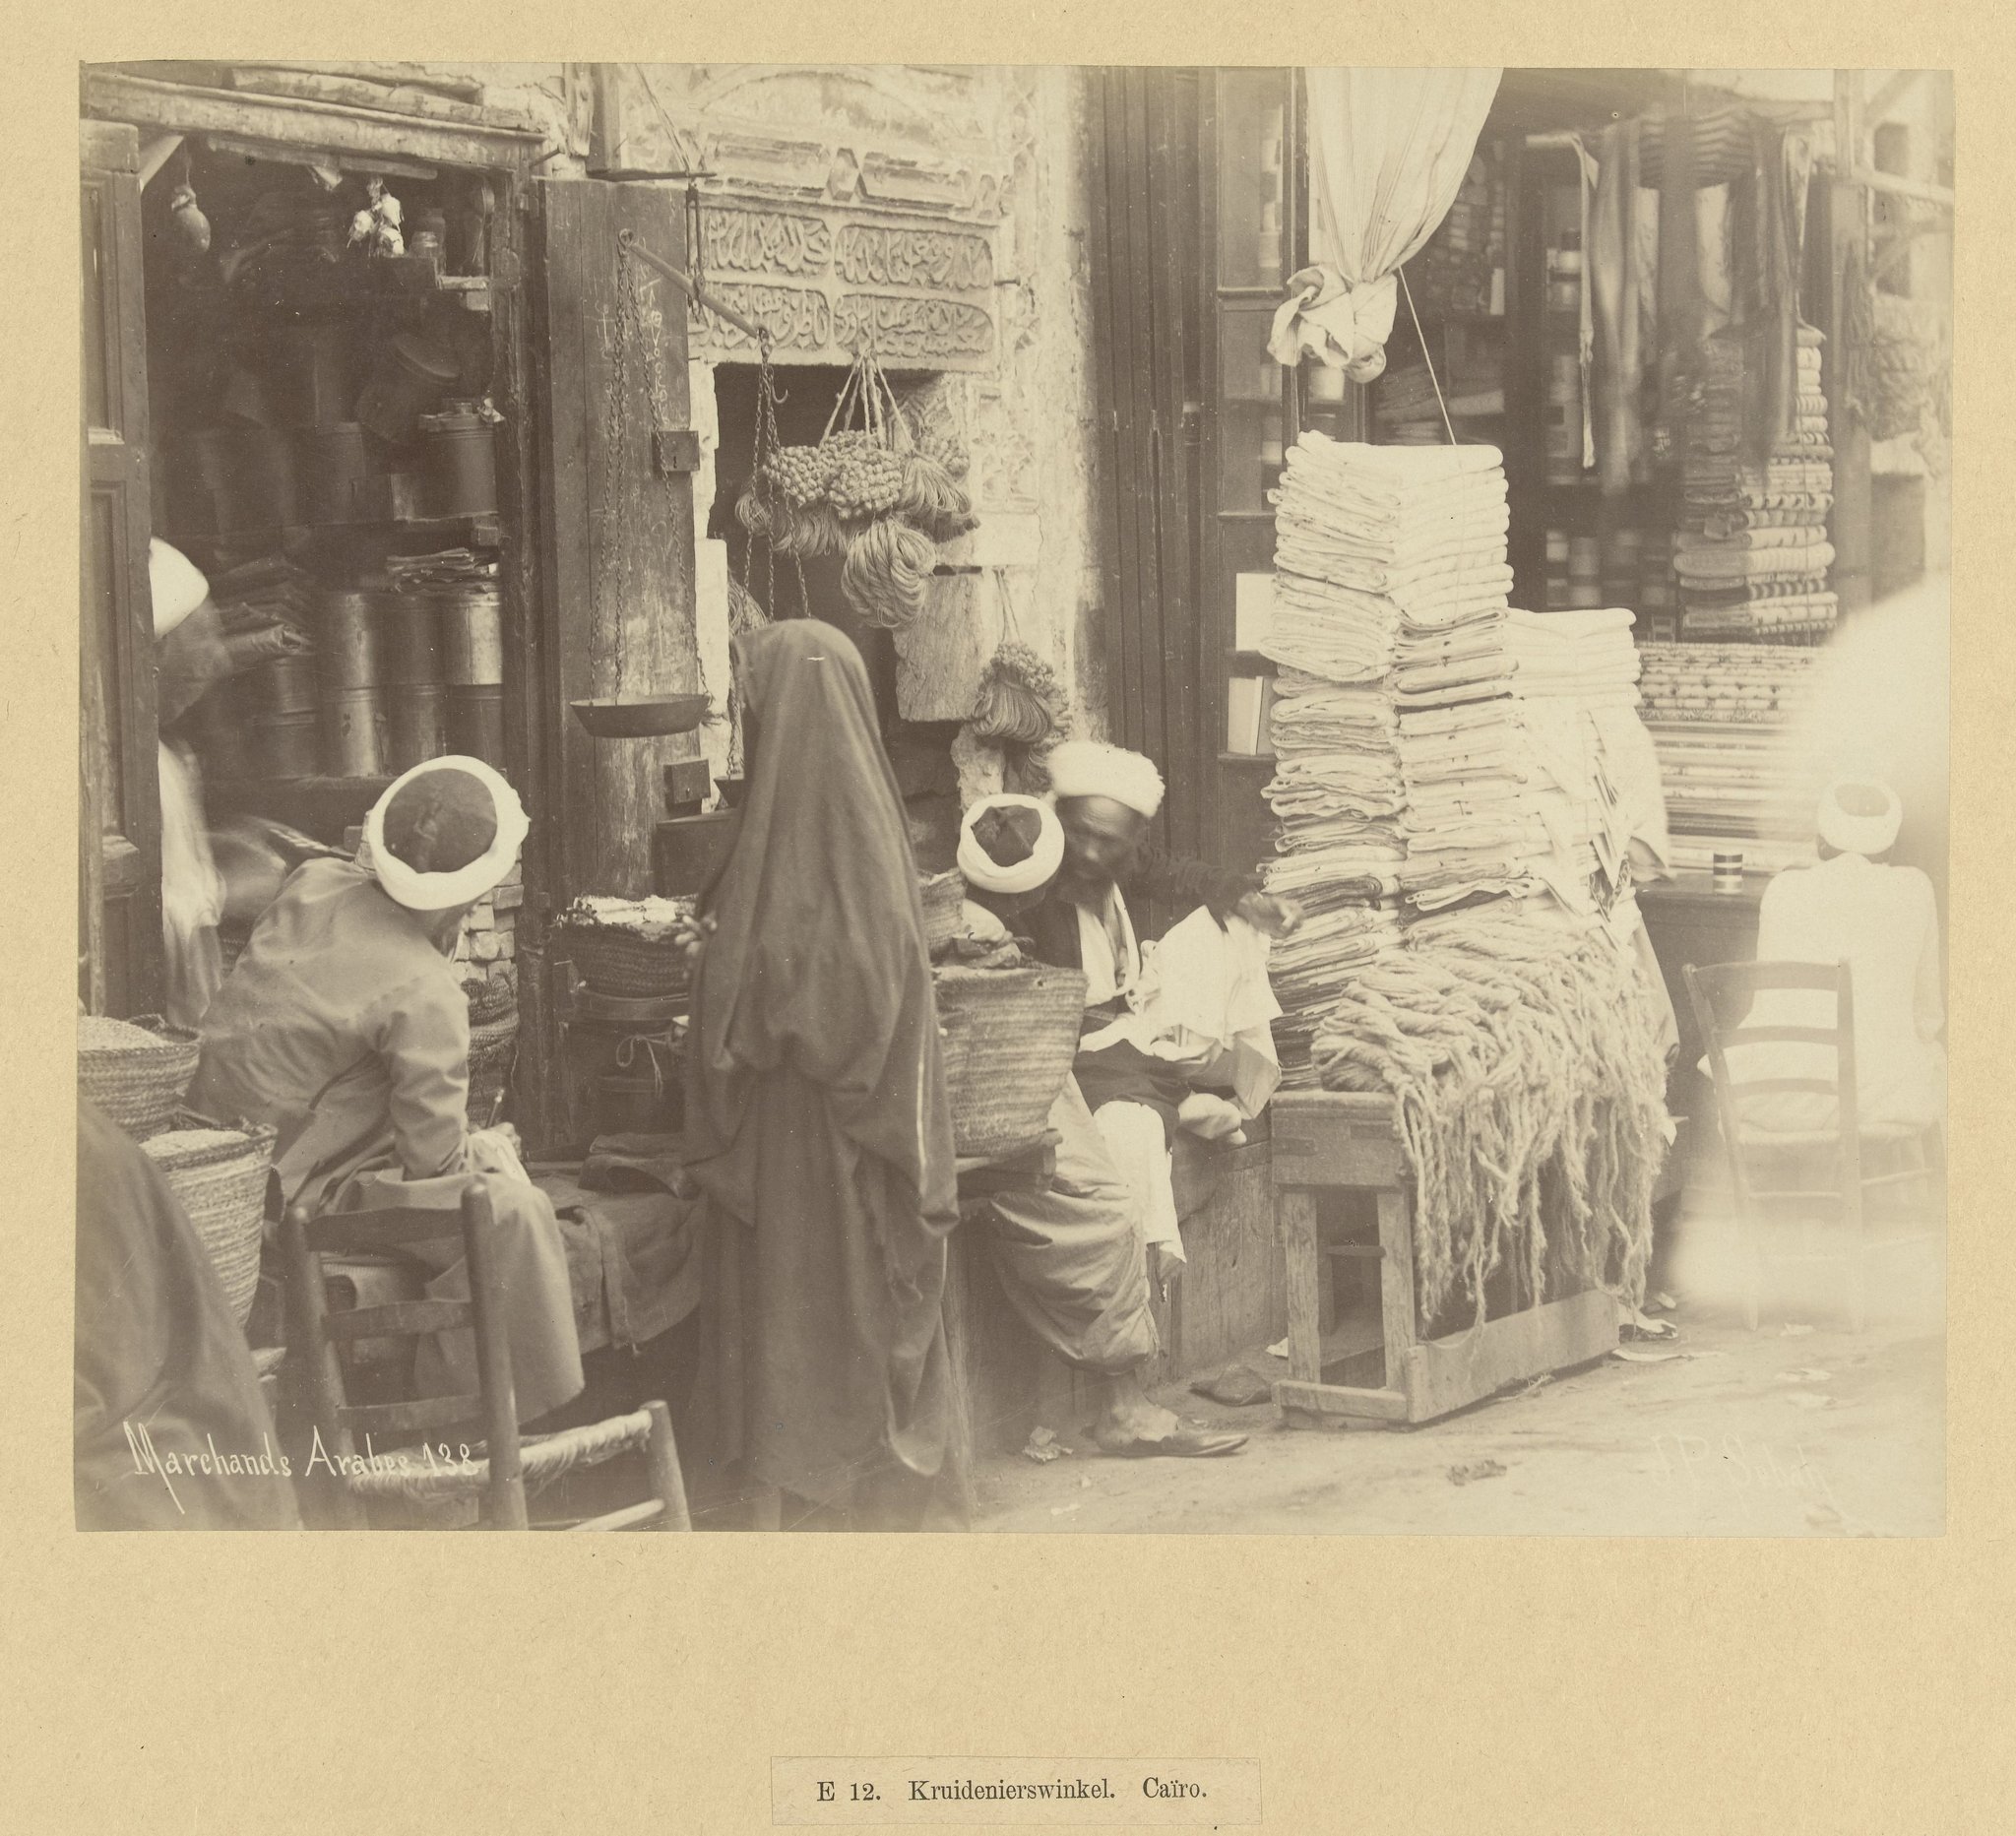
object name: photograph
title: Marchands Arabes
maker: jean pascal sébah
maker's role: fotograaf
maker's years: 1872-1947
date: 1888-1895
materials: cardboard, paper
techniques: albumen print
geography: cairo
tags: shop, store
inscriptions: stamp: ‘Gemeentelijke bibliotheek/ Rotterdam’, number: ‘138’, check stamp: ‘Bristol/ L.M.’, title: ‘E 12. Kruidenierswinkel. Caïro.’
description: Onderdeel van een groep door fotograaf Richard Polak op reis verzamelde foto’s. Deze foto is samen met andere op zijn reizen verzamelde foto's tentoongesteld bij de Rotterdamsche Kunstkring (1895), Arti en Amicitiae te Amsterdam (1897-1898?) en Societeit 't Collegie te Kampen (datum vooralsnog onbekend).